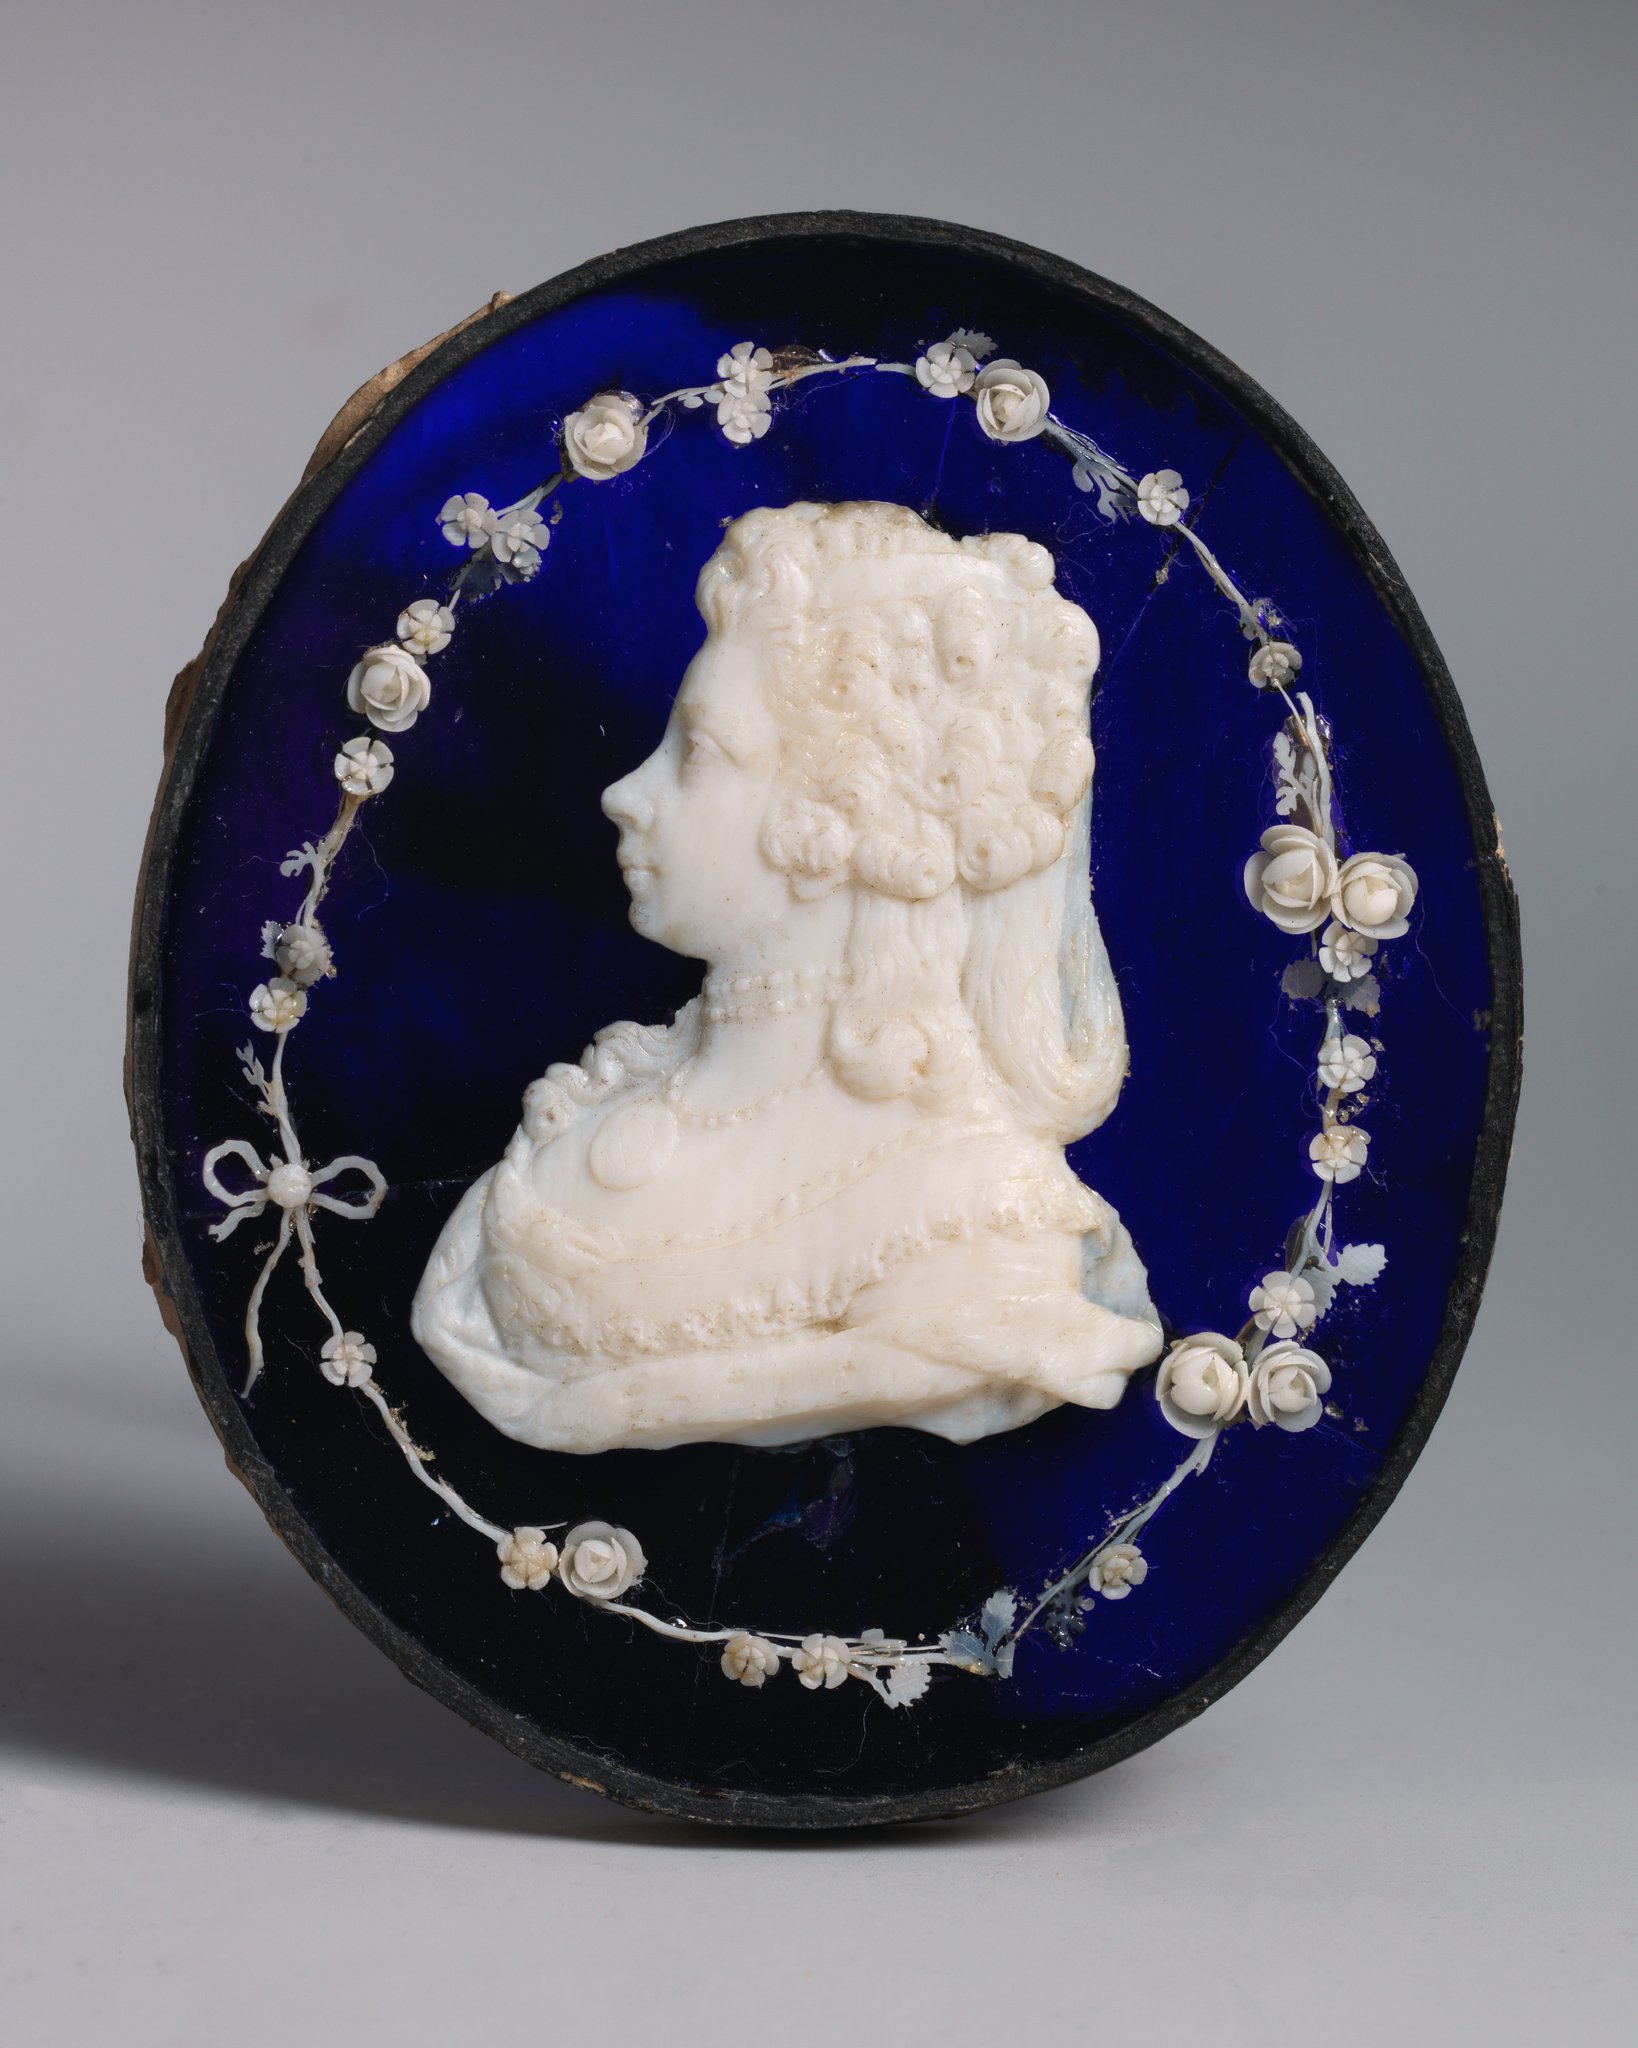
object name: relief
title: Queen Charlotte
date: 1765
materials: glass, ivory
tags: garlands,queens,profiles